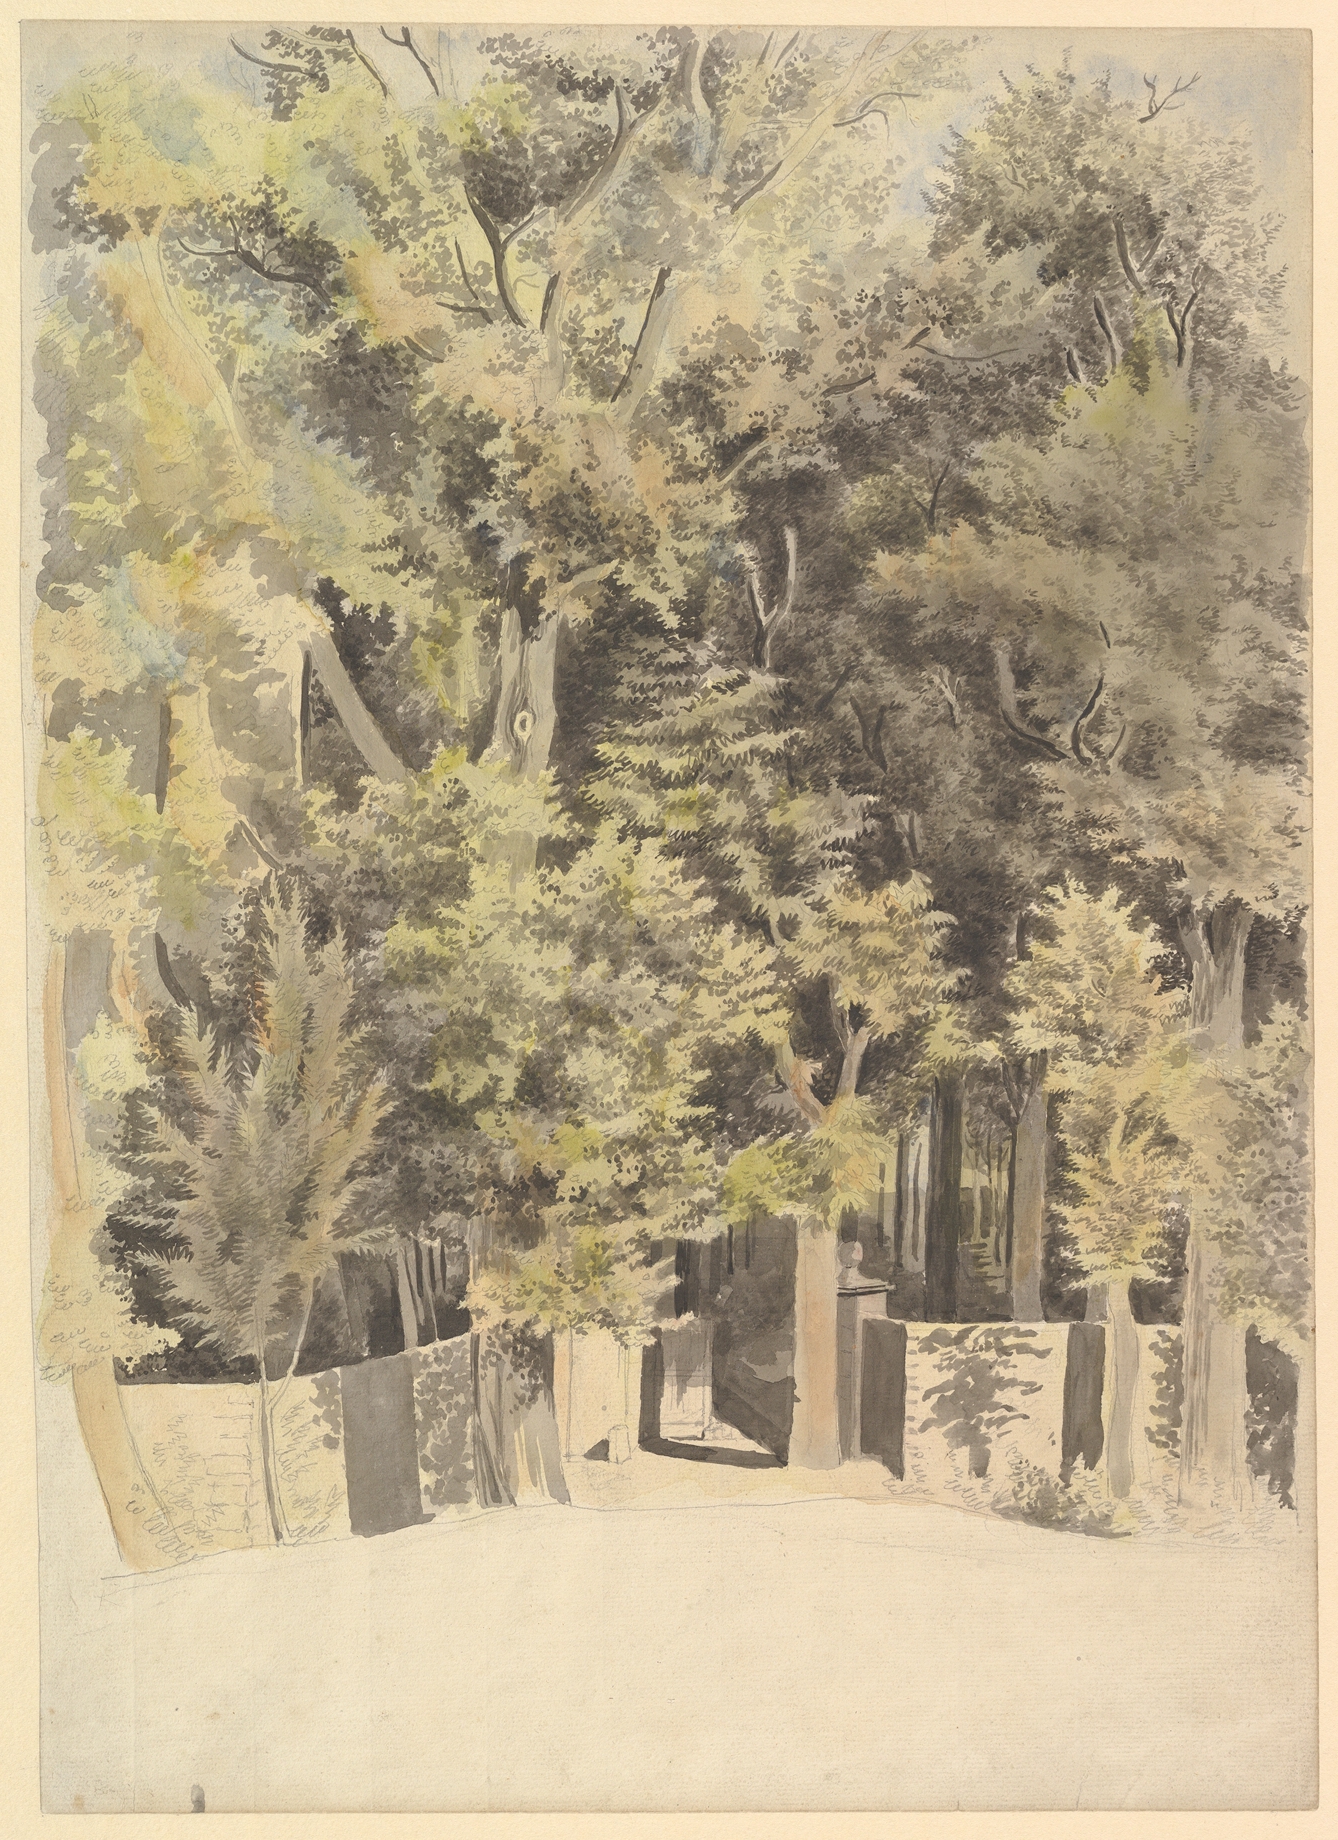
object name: drawing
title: Trees by an entrance to a park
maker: theodosius forrest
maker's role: artist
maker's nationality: british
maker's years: 1728-1784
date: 1760-1775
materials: graphite, watercolor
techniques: brush, wash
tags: parks,trees